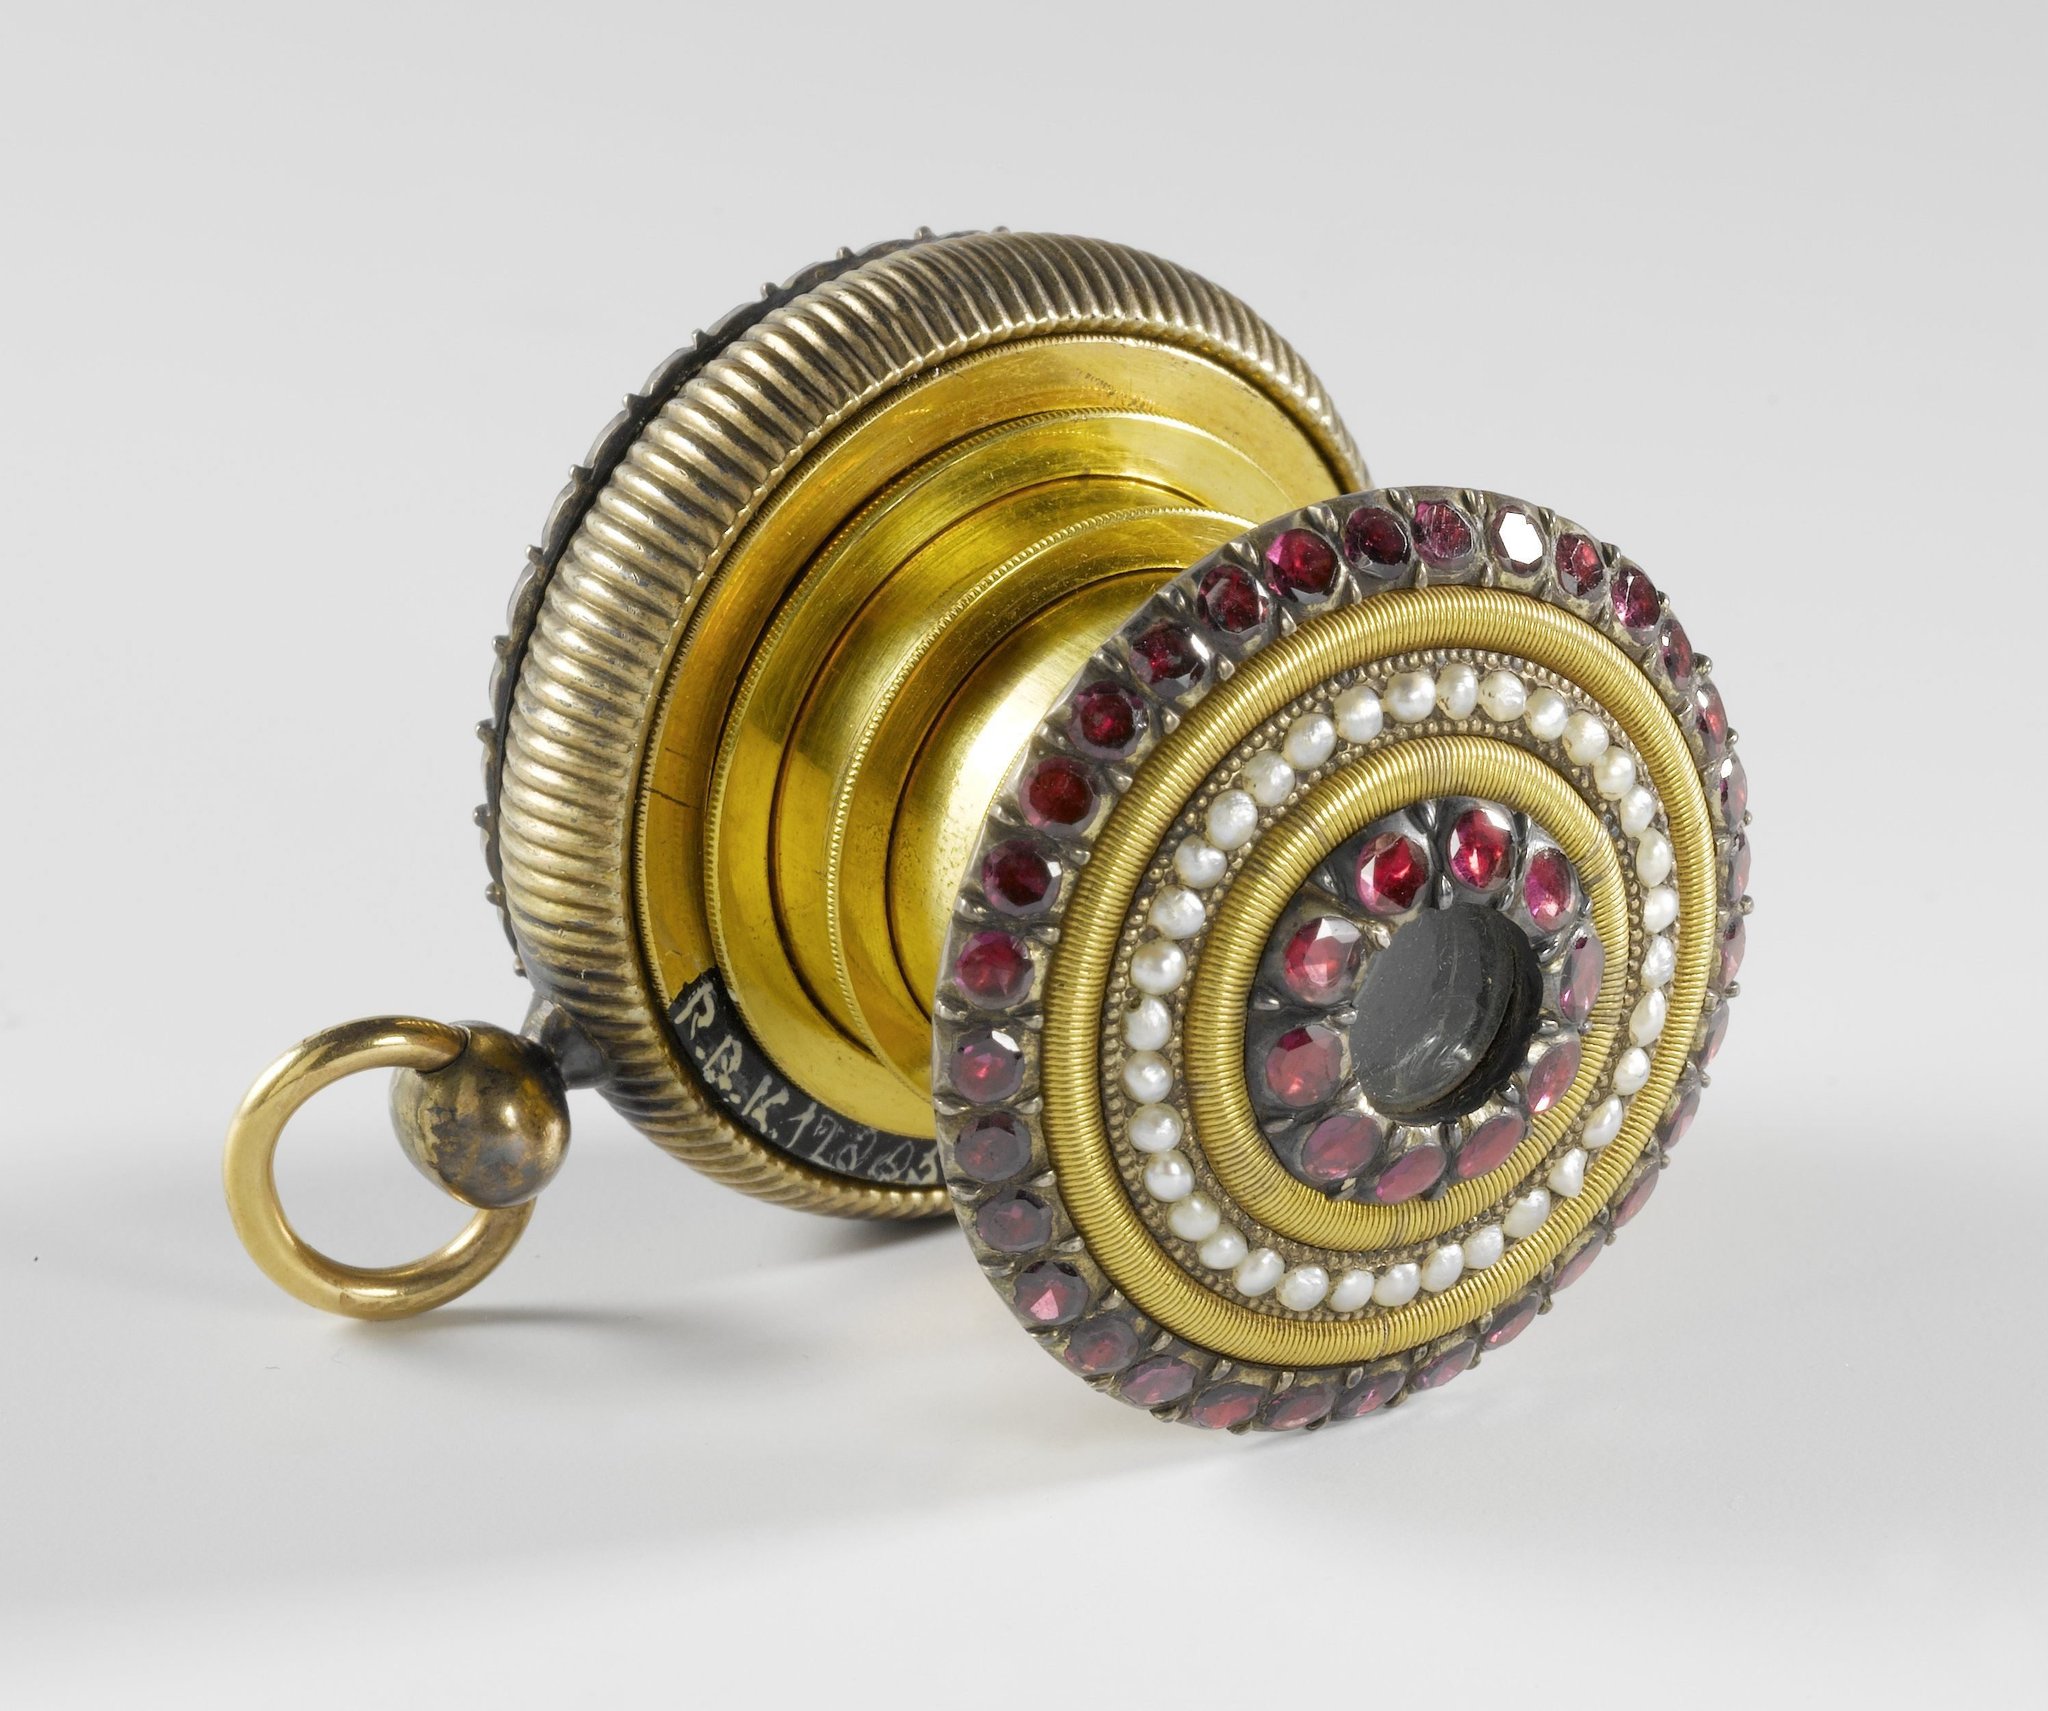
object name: opera glass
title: Toneelkijker in de vorm van een hanger (medaillon)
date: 1830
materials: glass, gold, pearl, gemstone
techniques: forging, grinding, inlay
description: Gouden inschuifbare toneelkijker met een kijkglas in de vorm van een hanger (medaillon), versierd met parels en rode geslepen steentjes.